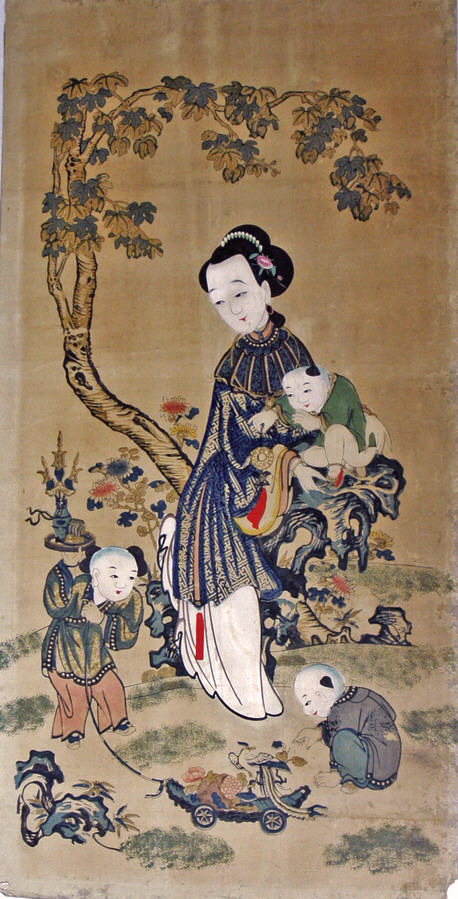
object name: print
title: Woman Playing with Three Children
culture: chinese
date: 1801-1900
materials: ink, paper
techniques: polychrome, woodblock print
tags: children,women,playing,toys